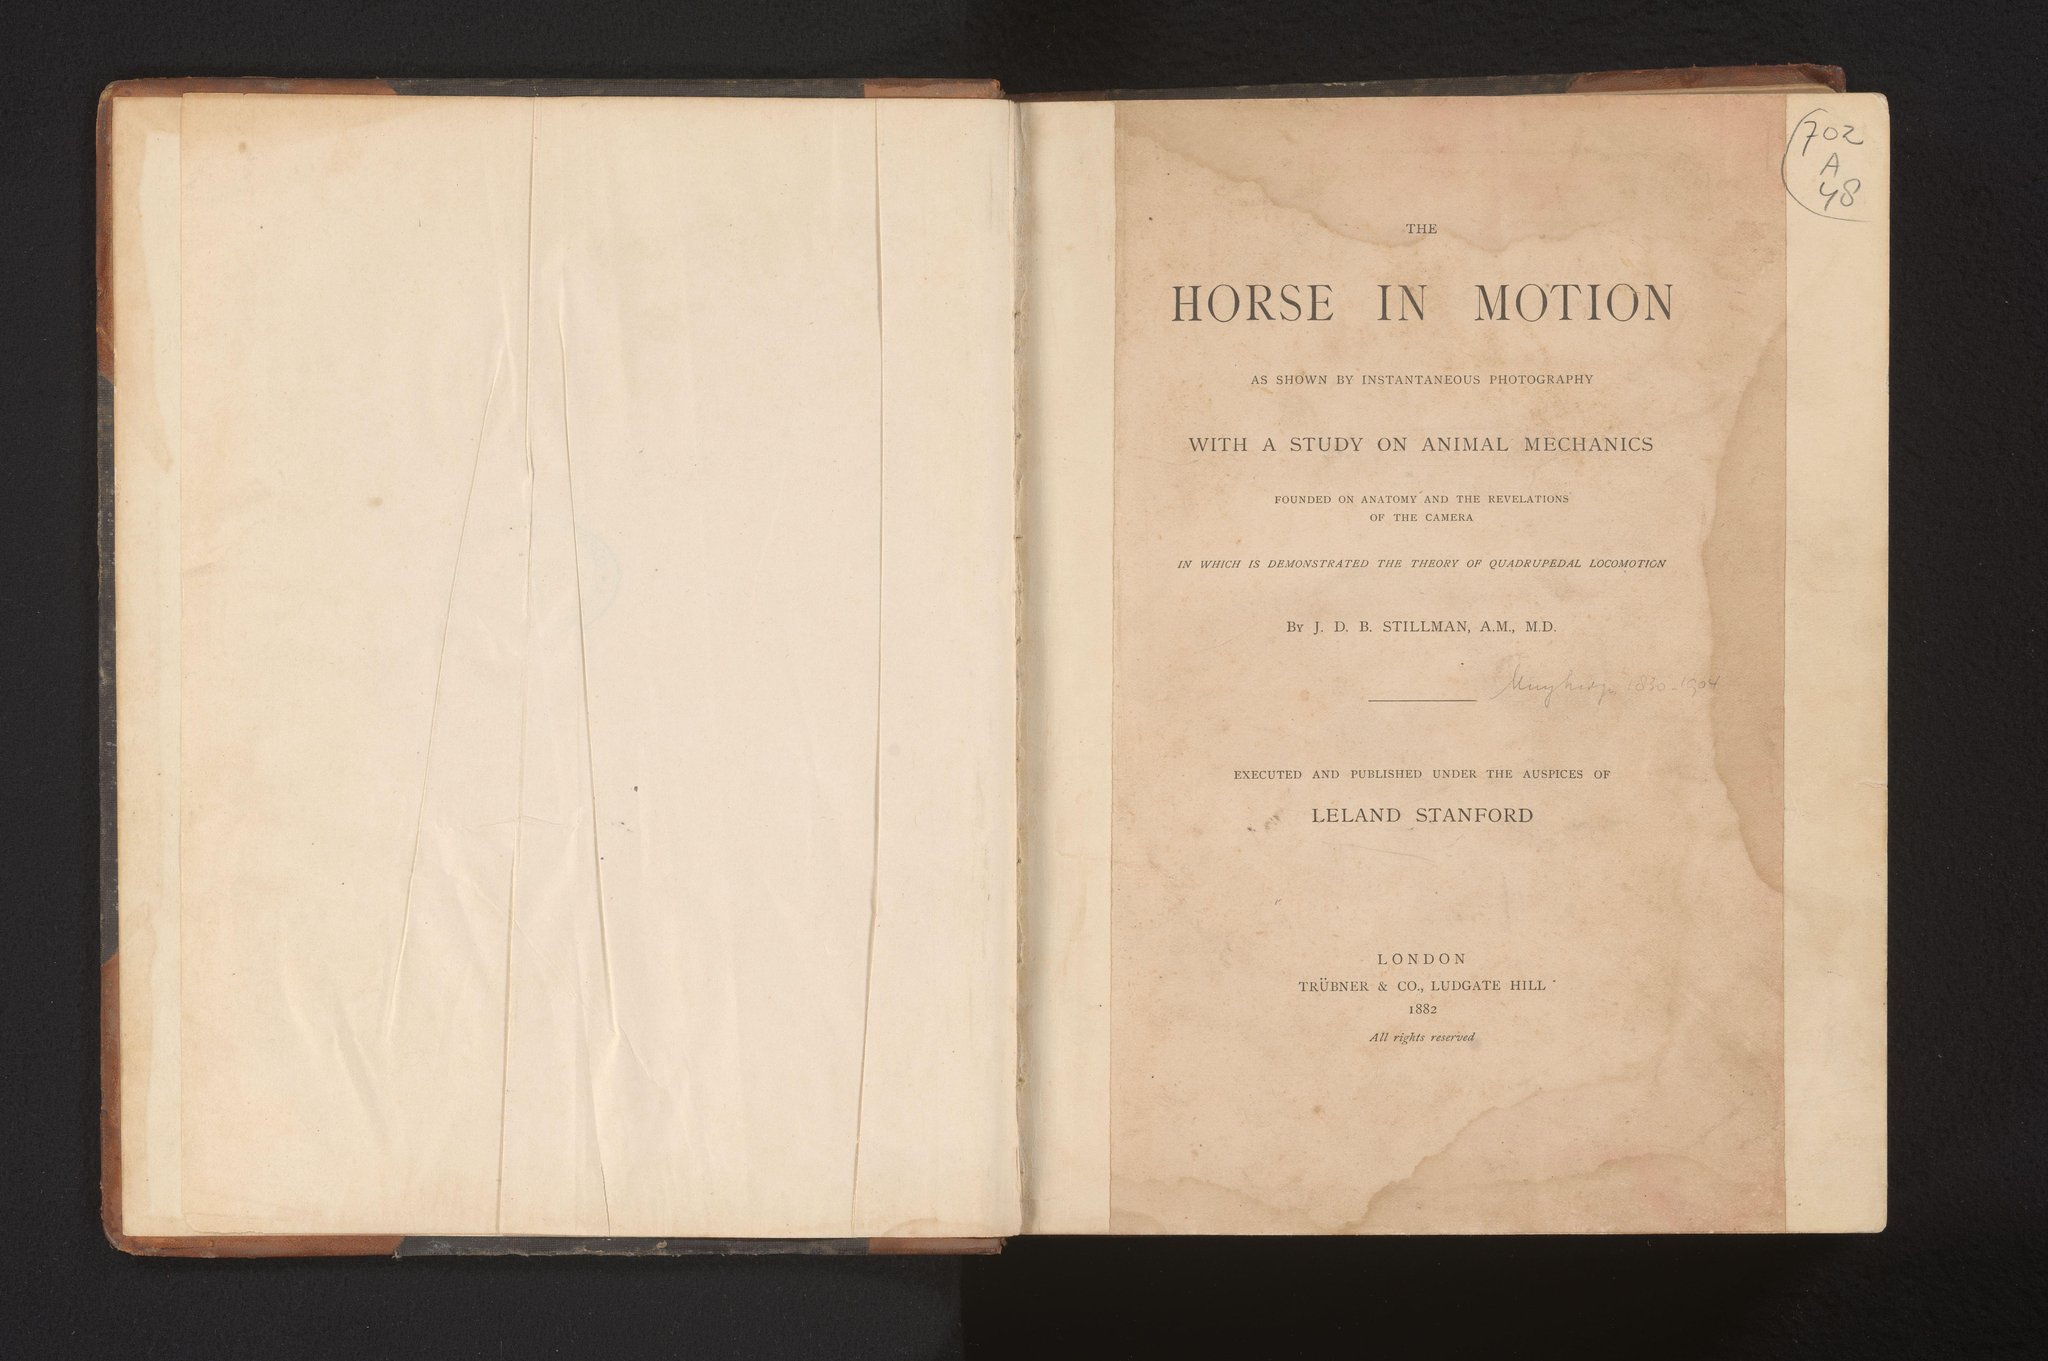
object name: book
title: The horse in motion: as shown by instantaneous photography with a study on animal mechanics founded on anatomy and the revelations of the camera in which is demonstrated the theory of quadrupedal locomotion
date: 1882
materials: cardboard, leather, paper, textile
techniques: lithograph, heliotype, letterpress printing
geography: bangalore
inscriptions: stamp: ‘Serofants' Mess/ 49/ The Queen's Bay’, number: ‘6A’